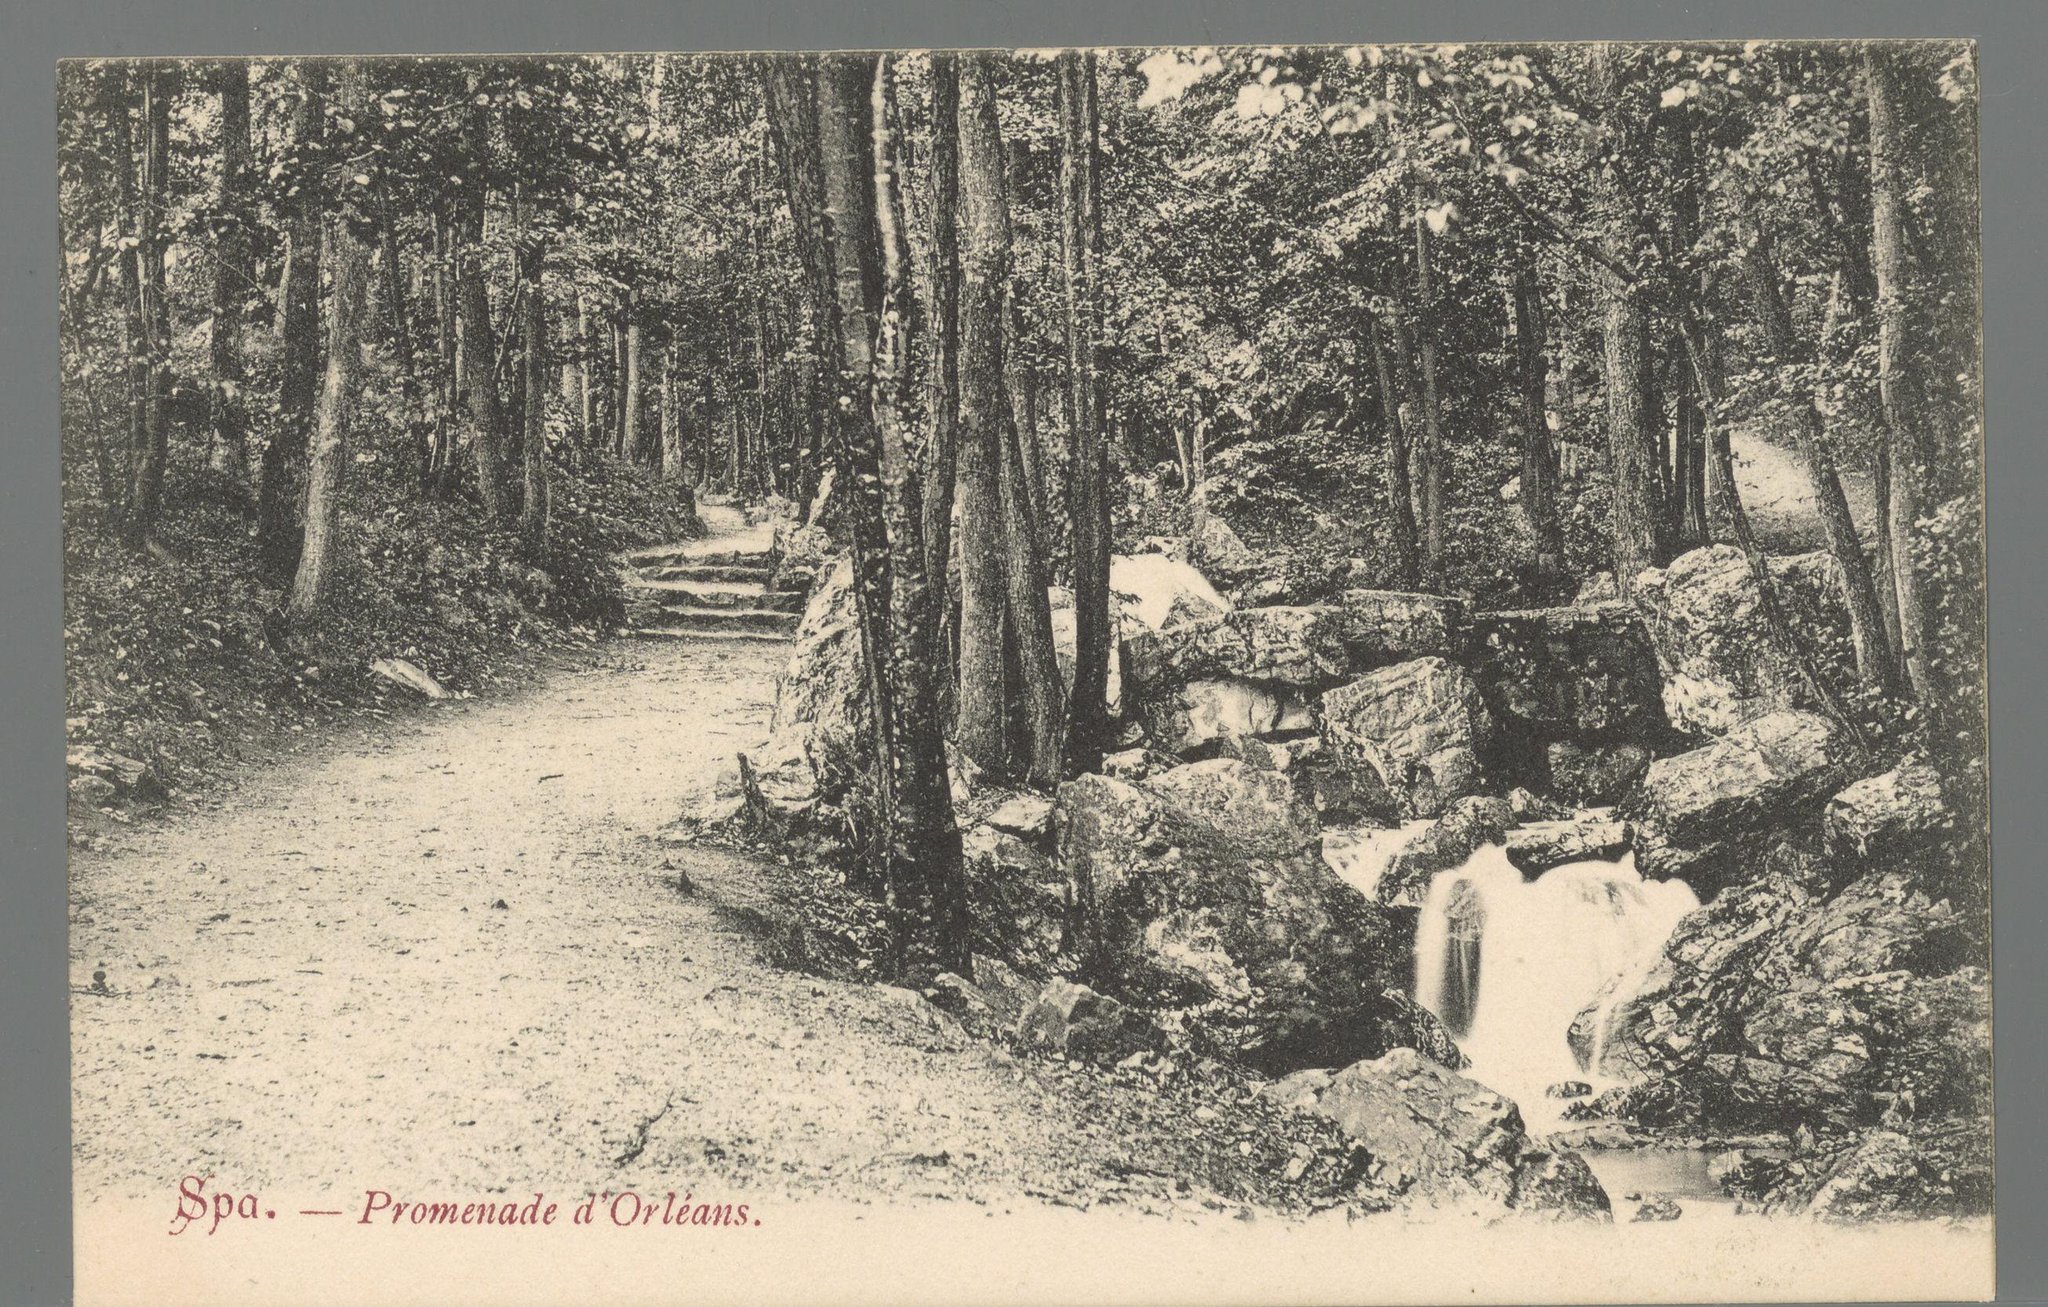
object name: ansichtkaart, prentbriefkaart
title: Spa. Promenade d'Orléans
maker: Anonymous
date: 1892-1906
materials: cardboard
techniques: photograph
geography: spa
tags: forest, wood